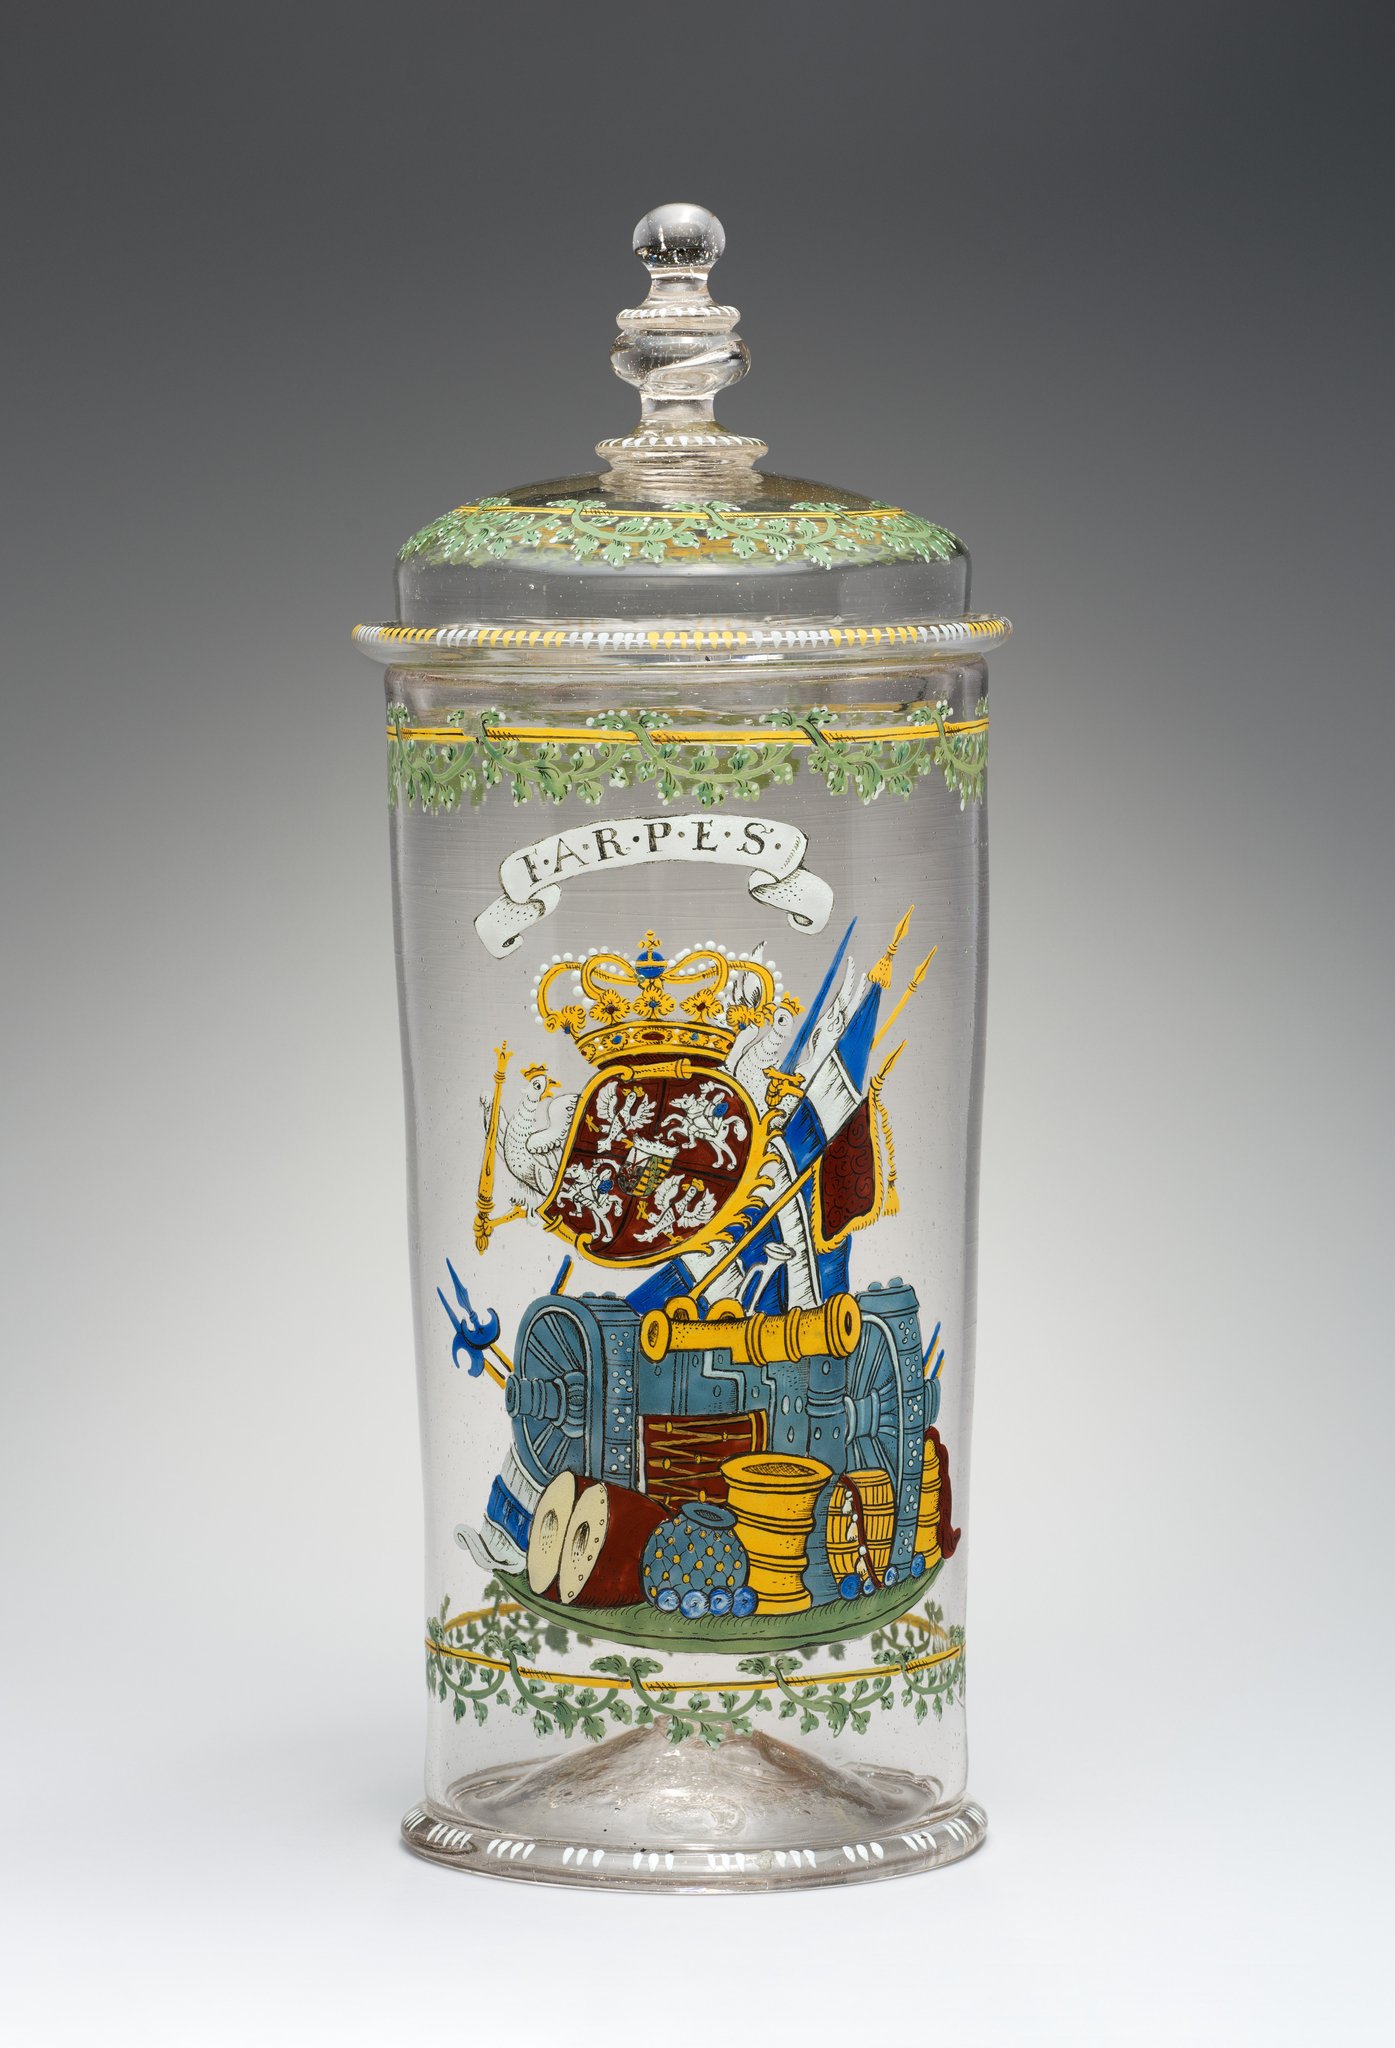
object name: beaker with cover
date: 1667-1733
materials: glass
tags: coat of arms